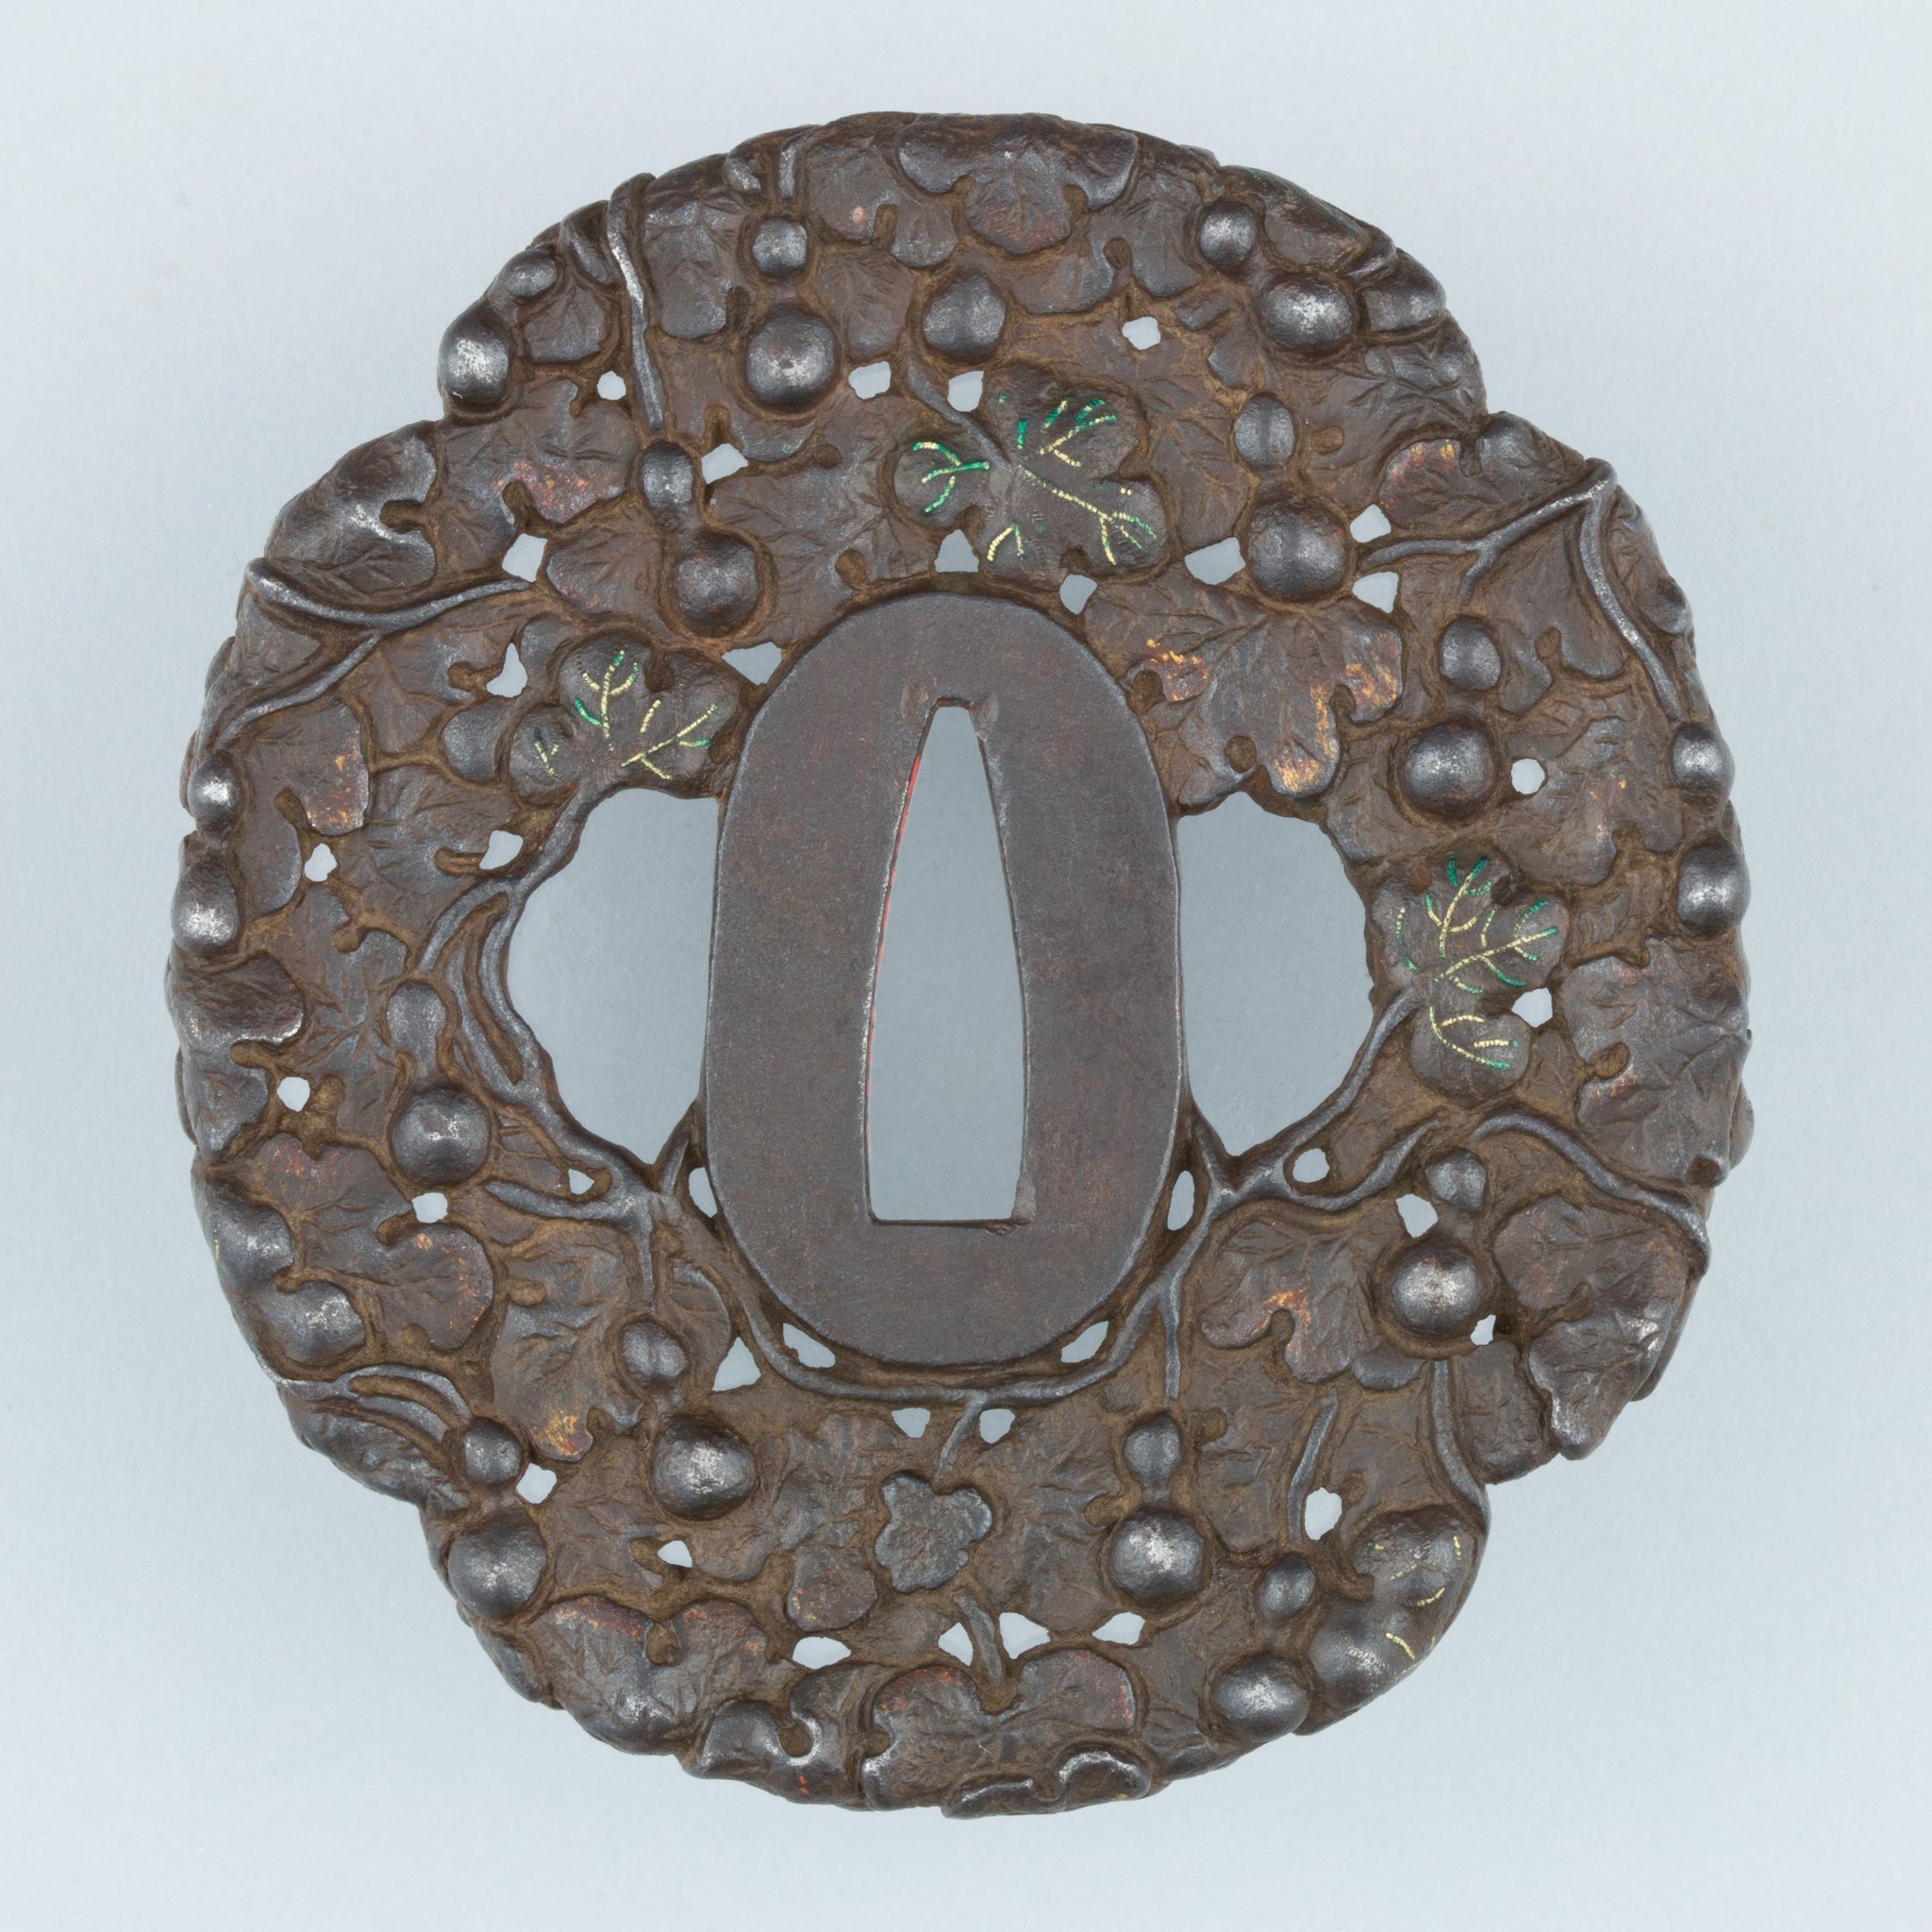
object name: sword guard tsuba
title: Sword Guard (Tsuba)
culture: japanese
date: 1615-1868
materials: copper, enamel, gold, iron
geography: japan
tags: leaves,vines